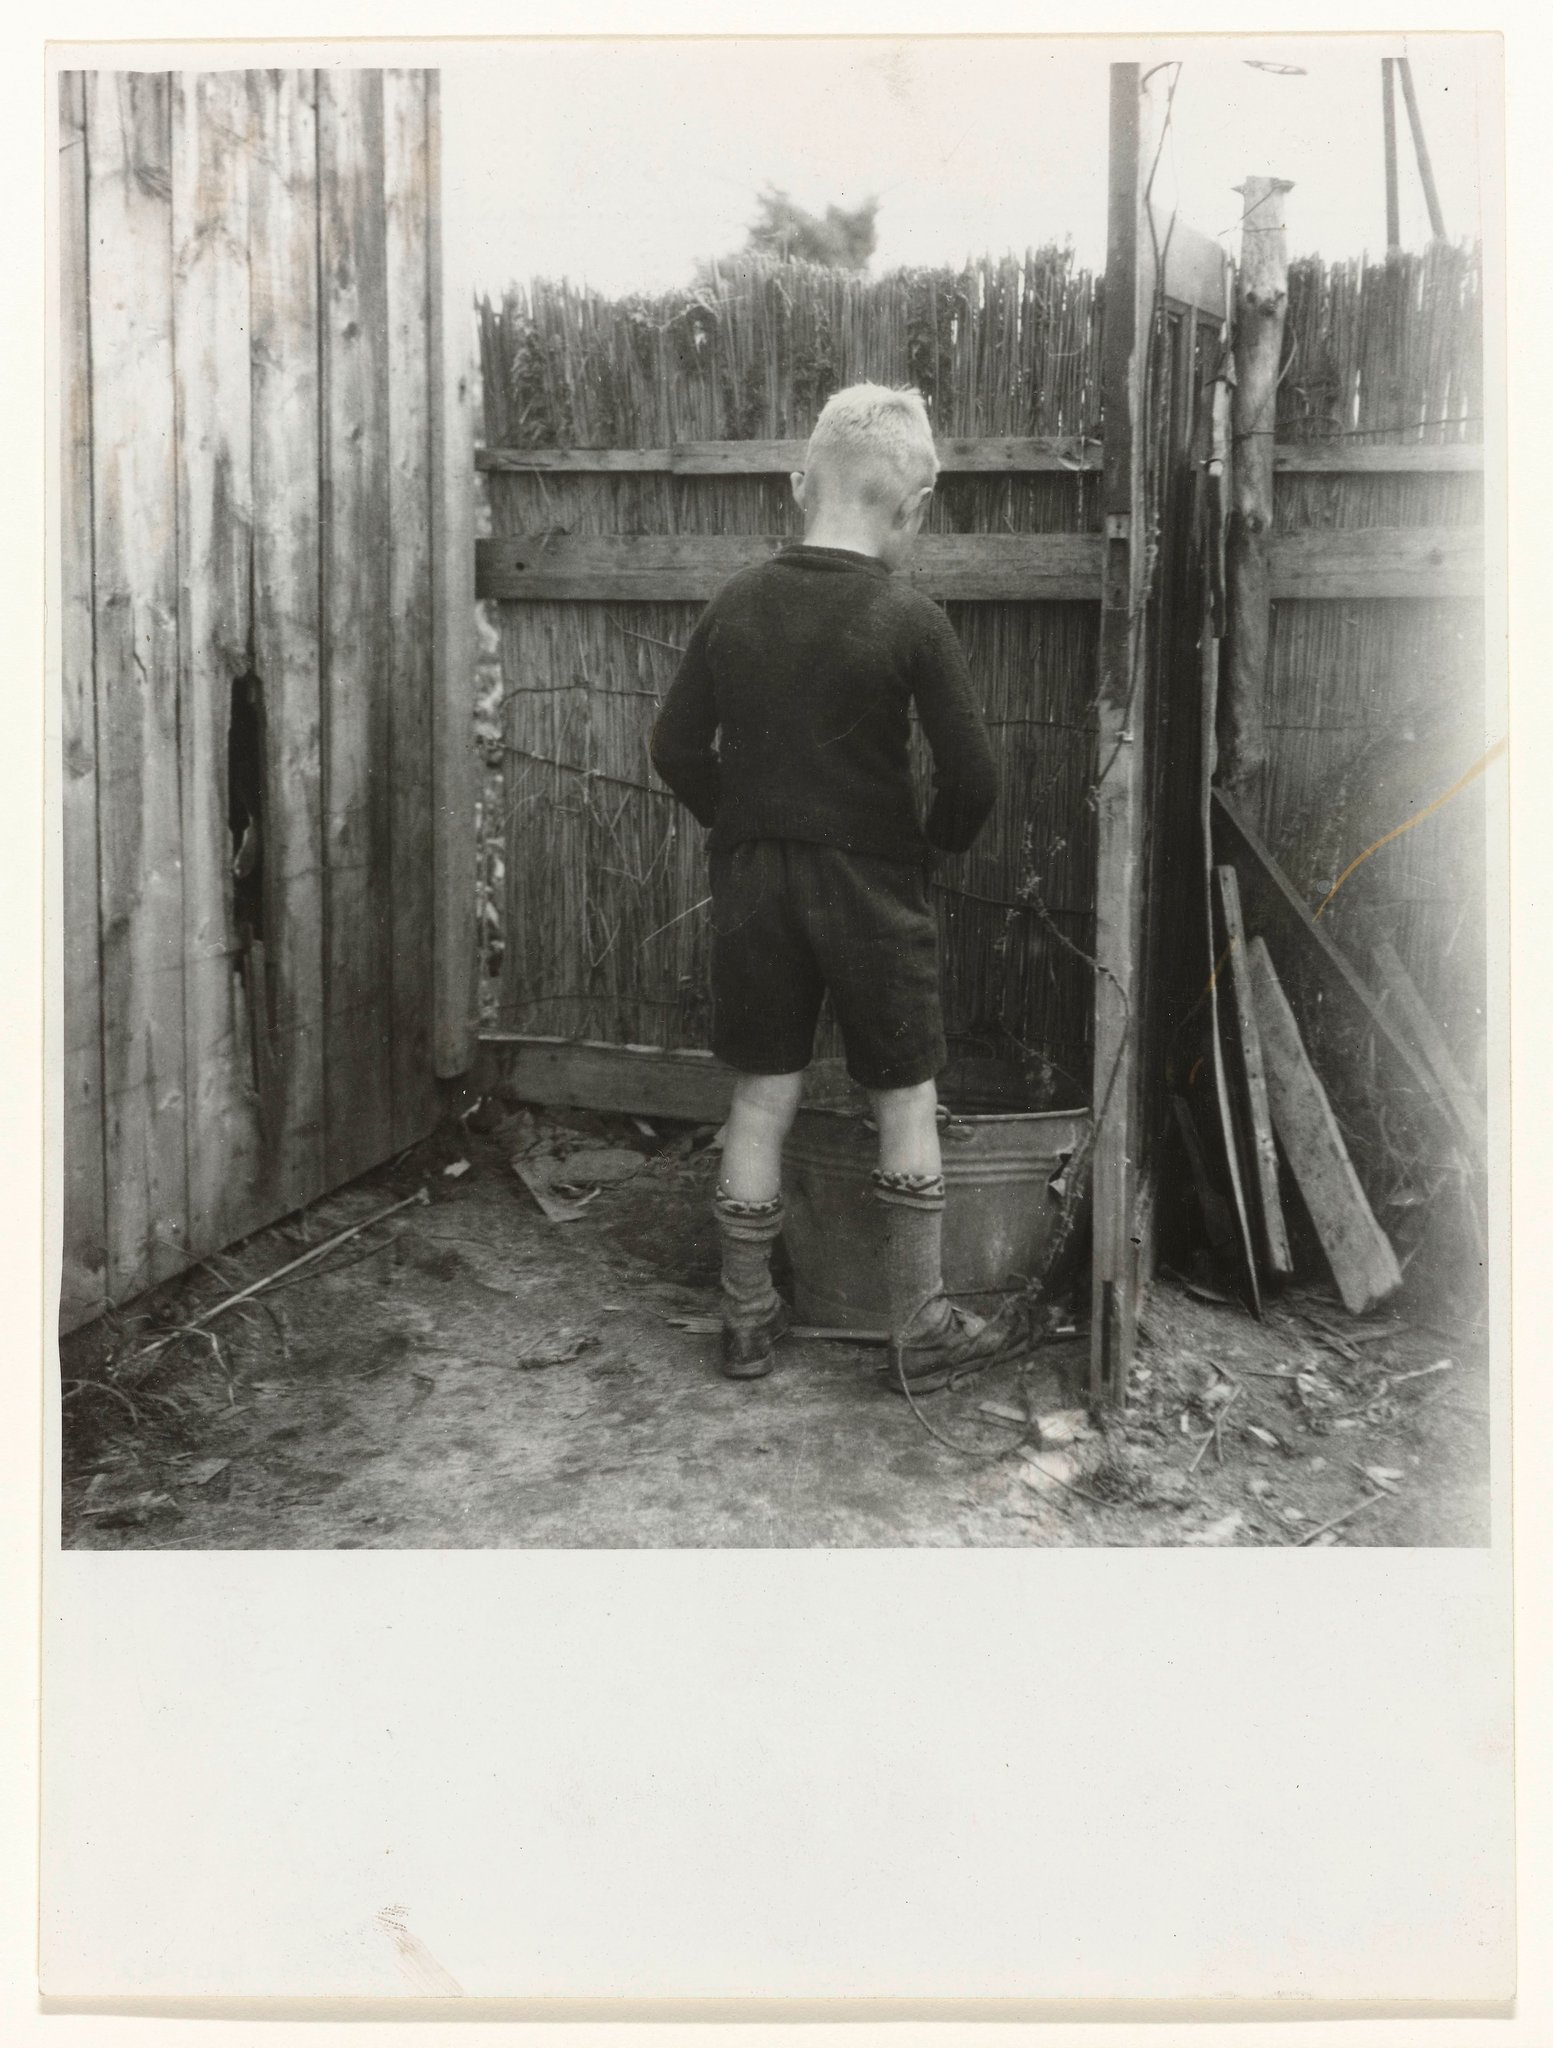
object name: documentary photograph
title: Plassend jongetje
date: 1945-1947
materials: photographic support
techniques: photography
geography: netherlands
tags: netherlands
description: Een jongetje, op de rug gezien, staat in een teil te plassen. Op de achtergrond een rieten schutting.